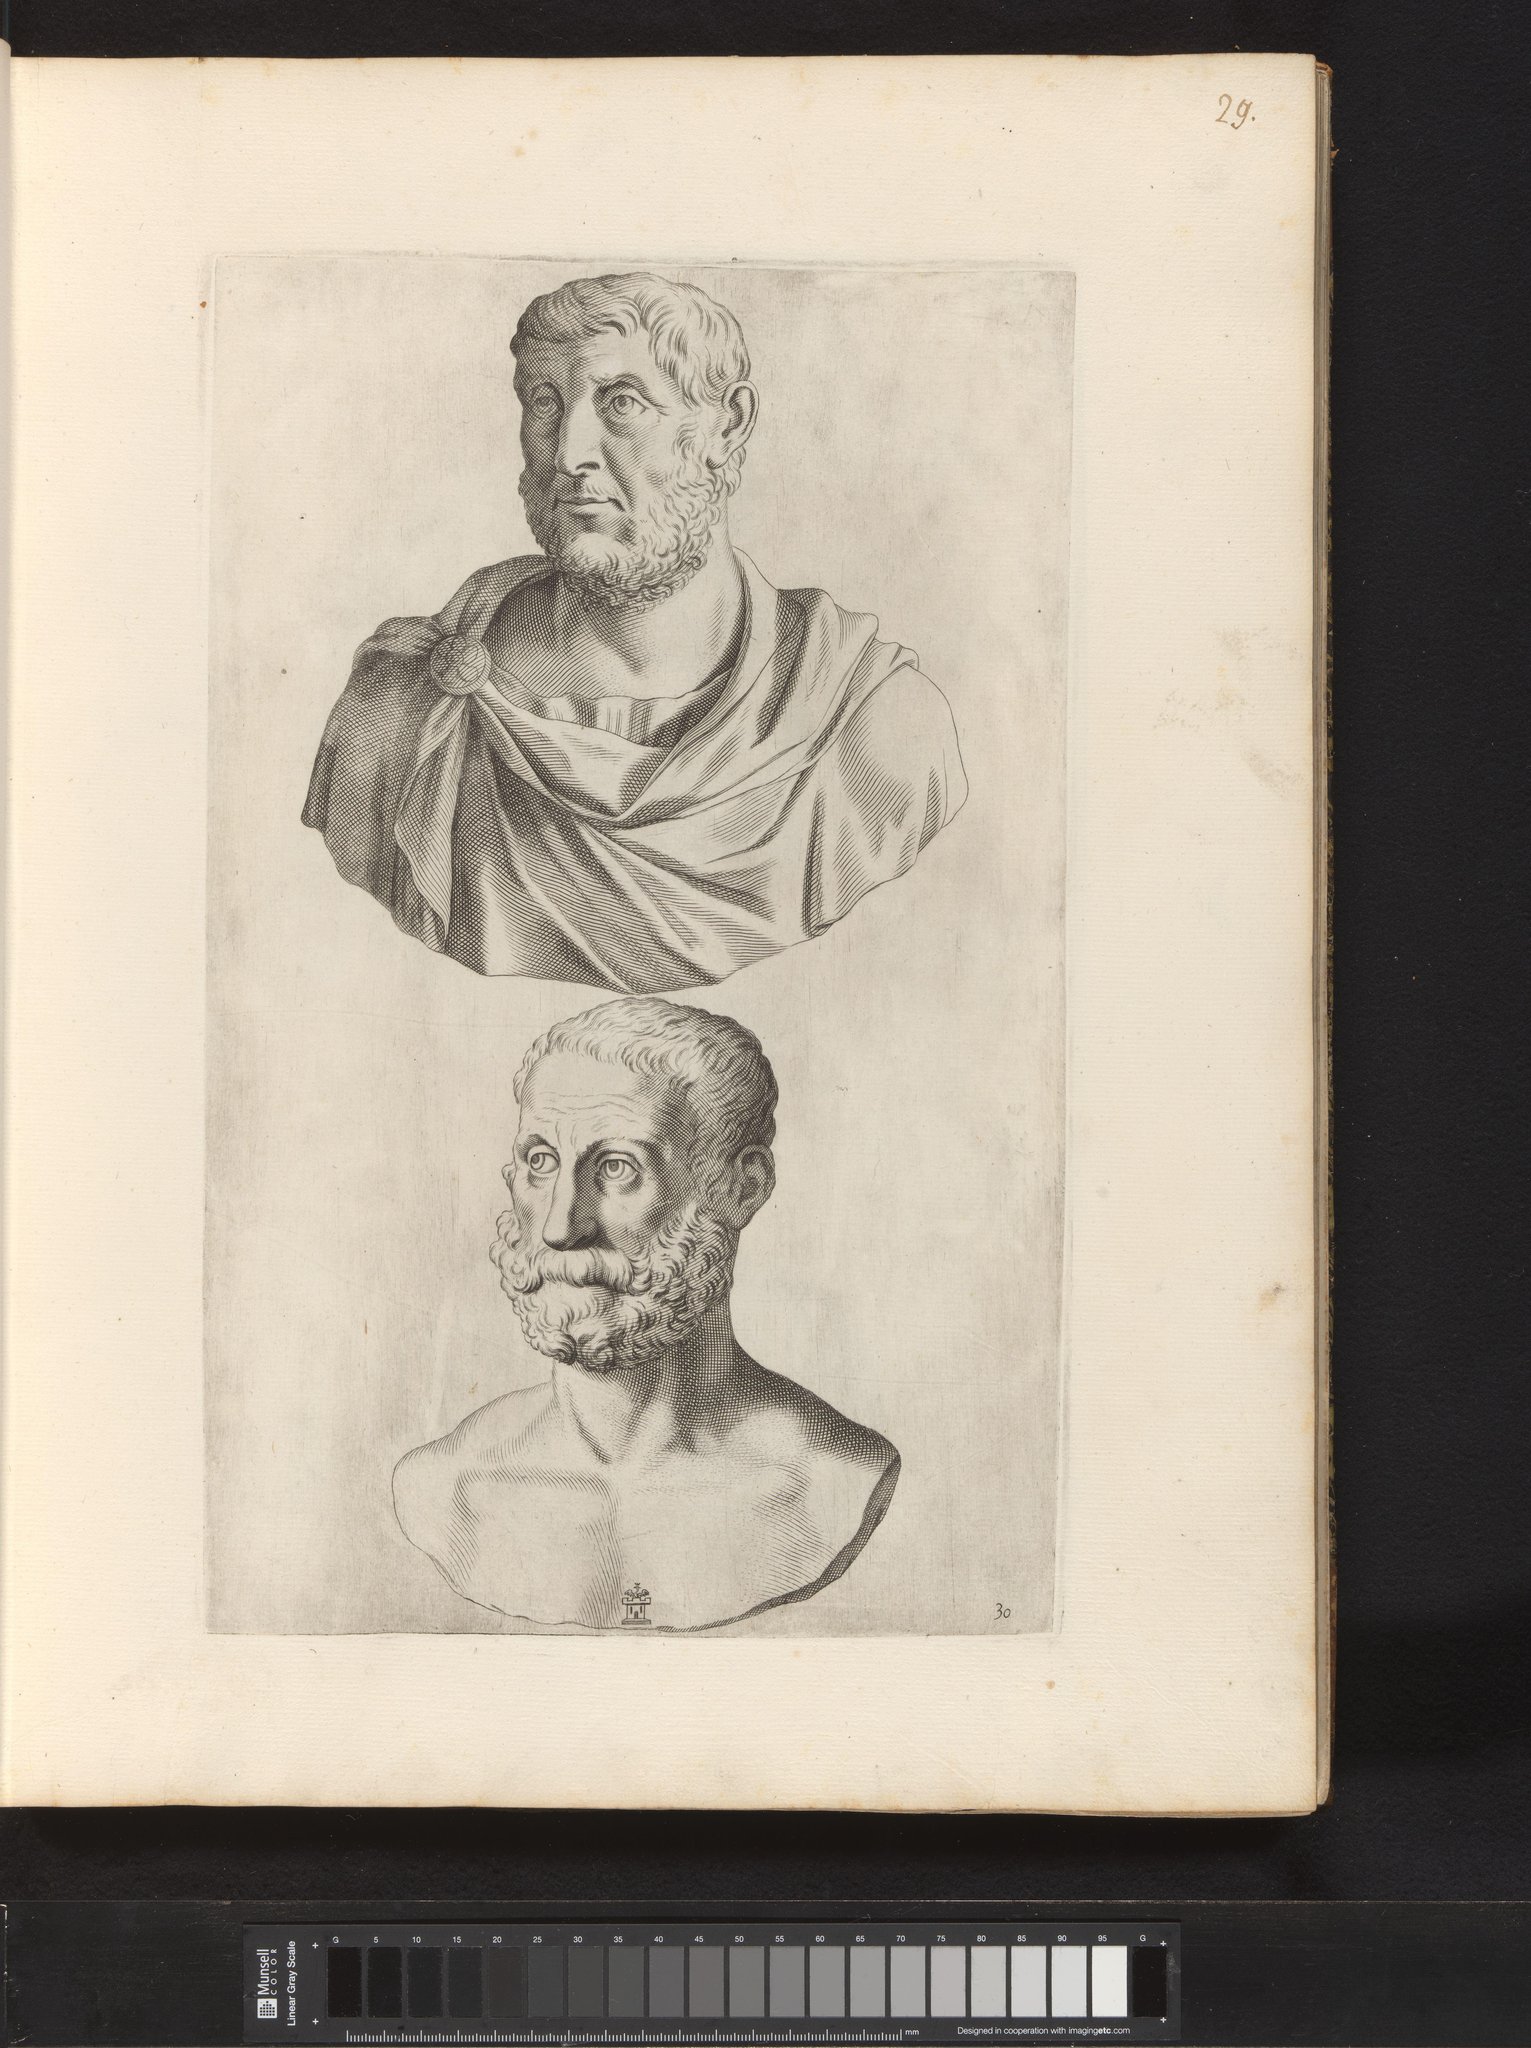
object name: print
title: Bustes van Homerus en Pindarus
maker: anna maria vaiani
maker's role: painter, print maker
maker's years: -1655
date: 1636-1647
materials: paper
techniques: engraving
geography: rome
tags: homerus, pindarus, male persons from classical history (+ head, bust, etc.), portrait of homer (+ head, bust, etc.), piece of sculpture, reproduction of a piece of sculpture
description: Bustes van de filosofen Homerus en Pindarus. Op de bustes het wapenschild van Vincenzo Giustiniani. Prent maakt deel uit van een album met een serie prenten naar de sculpturen in de verzameling in de Galleria Giustiniani te Rome.